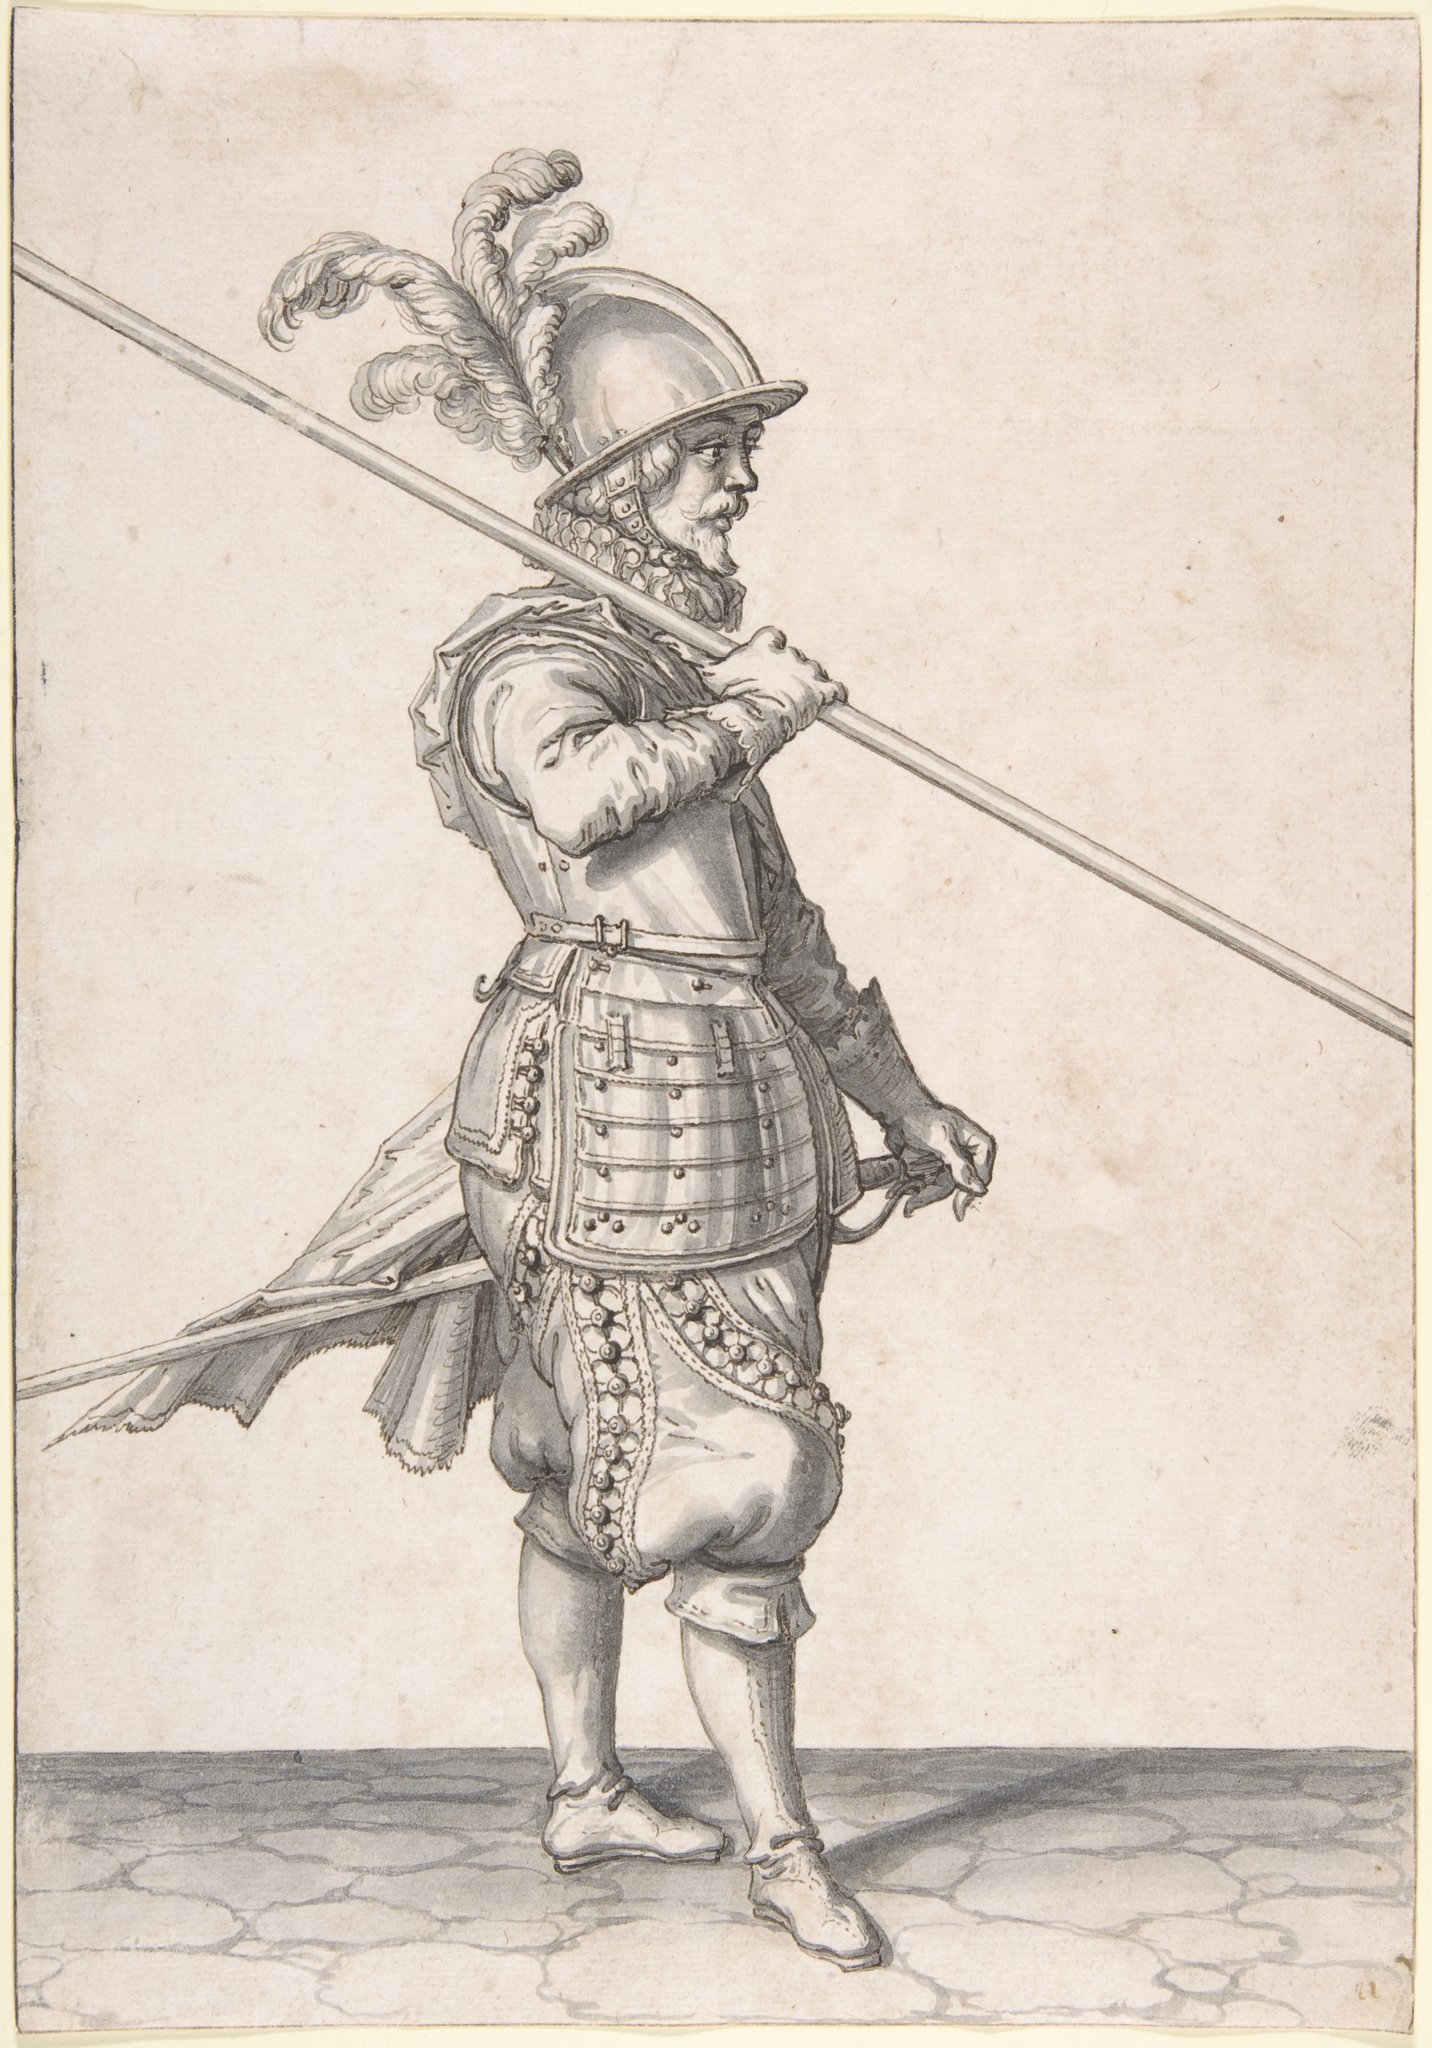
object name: drawing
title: The Soldier Carrying His Pike at the Slope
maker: jacques de gheyn (ii)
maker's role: artist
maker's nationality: netherlandish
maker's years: 1565-1629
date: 1567-1633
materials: ink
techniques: incising, pen, transfer, wash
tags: soldiers,weapons